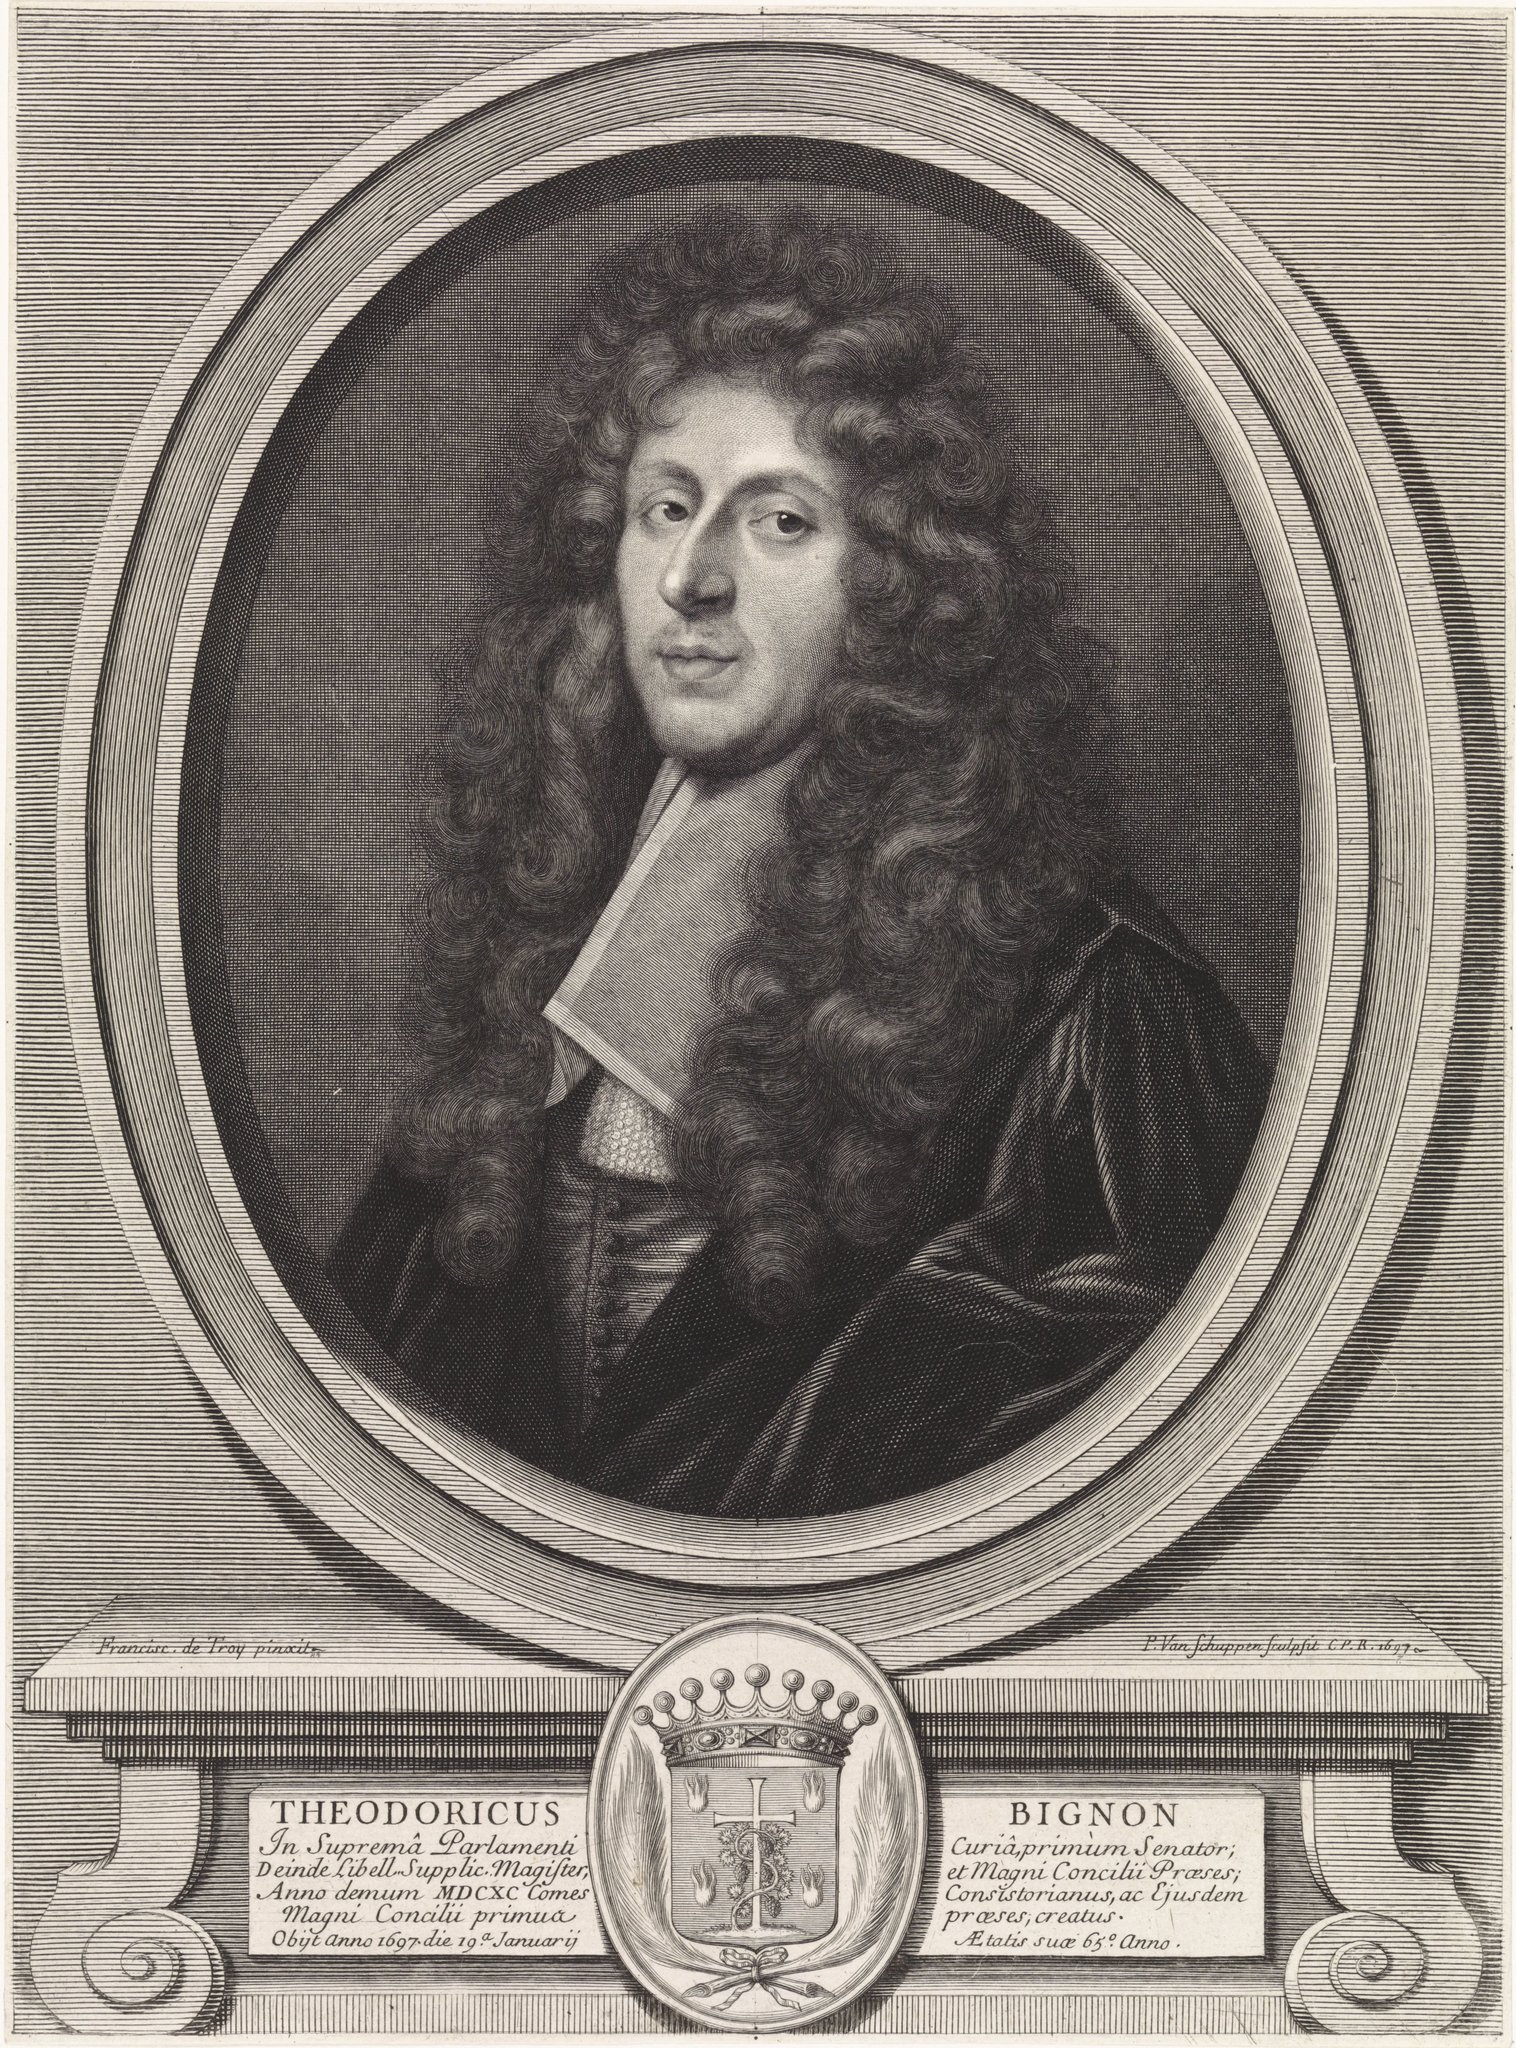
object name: print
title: Portret van Thierry Bignon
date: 1607-1697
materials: paper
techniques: engraving, etching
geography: paris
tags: staatsman, thierry bignon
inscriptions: collector's mark: Lugt 2228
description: Portret van de Franse staatsman Thierry Bignon op circa 52-jarige leeftijd. Onder het portret worden aan weerszijden van zijn wapenschild zijn naam, functies en sterfdatum weergegeven in het Latijn.